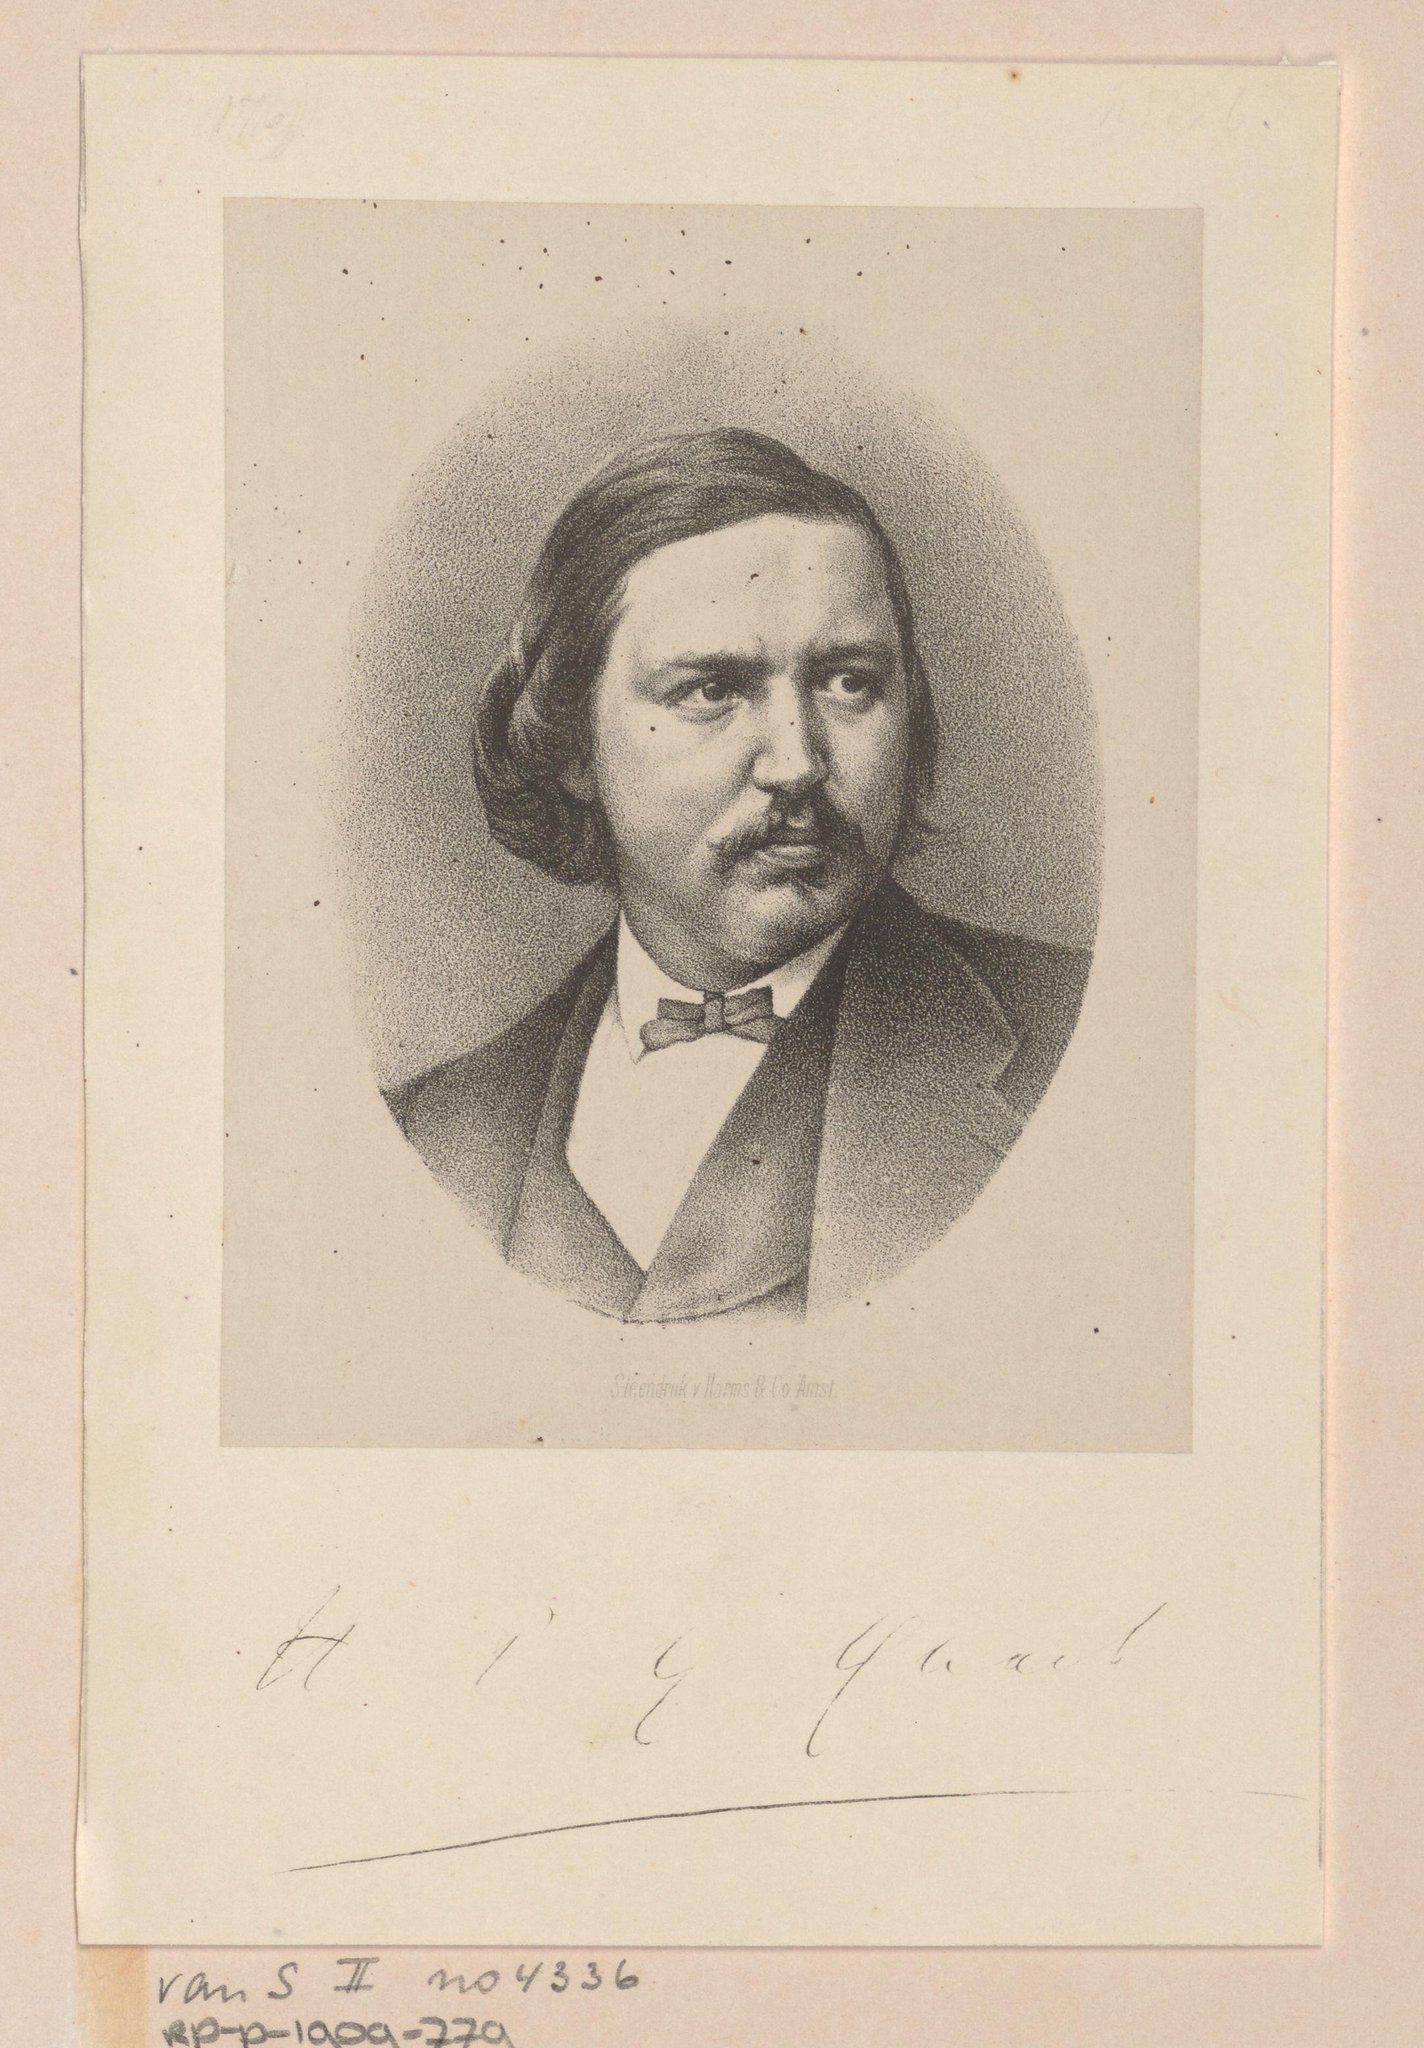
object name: print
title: Portret van Hendrick Peter Godfried Quack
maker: Anonymous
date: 1875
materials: paper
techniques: lithograph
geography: amsterdam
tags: amsterdam, hendrick peter godfried quack, historical persons, lawyer, attorney at law, professor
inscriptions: collector's mark: Lugt 2228, inscription: ‘Stud. Utr. Alm (...) M.Jr.z.526’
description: Prent mogelijk uit: Utrechtsche Studenten Almanak (1875).